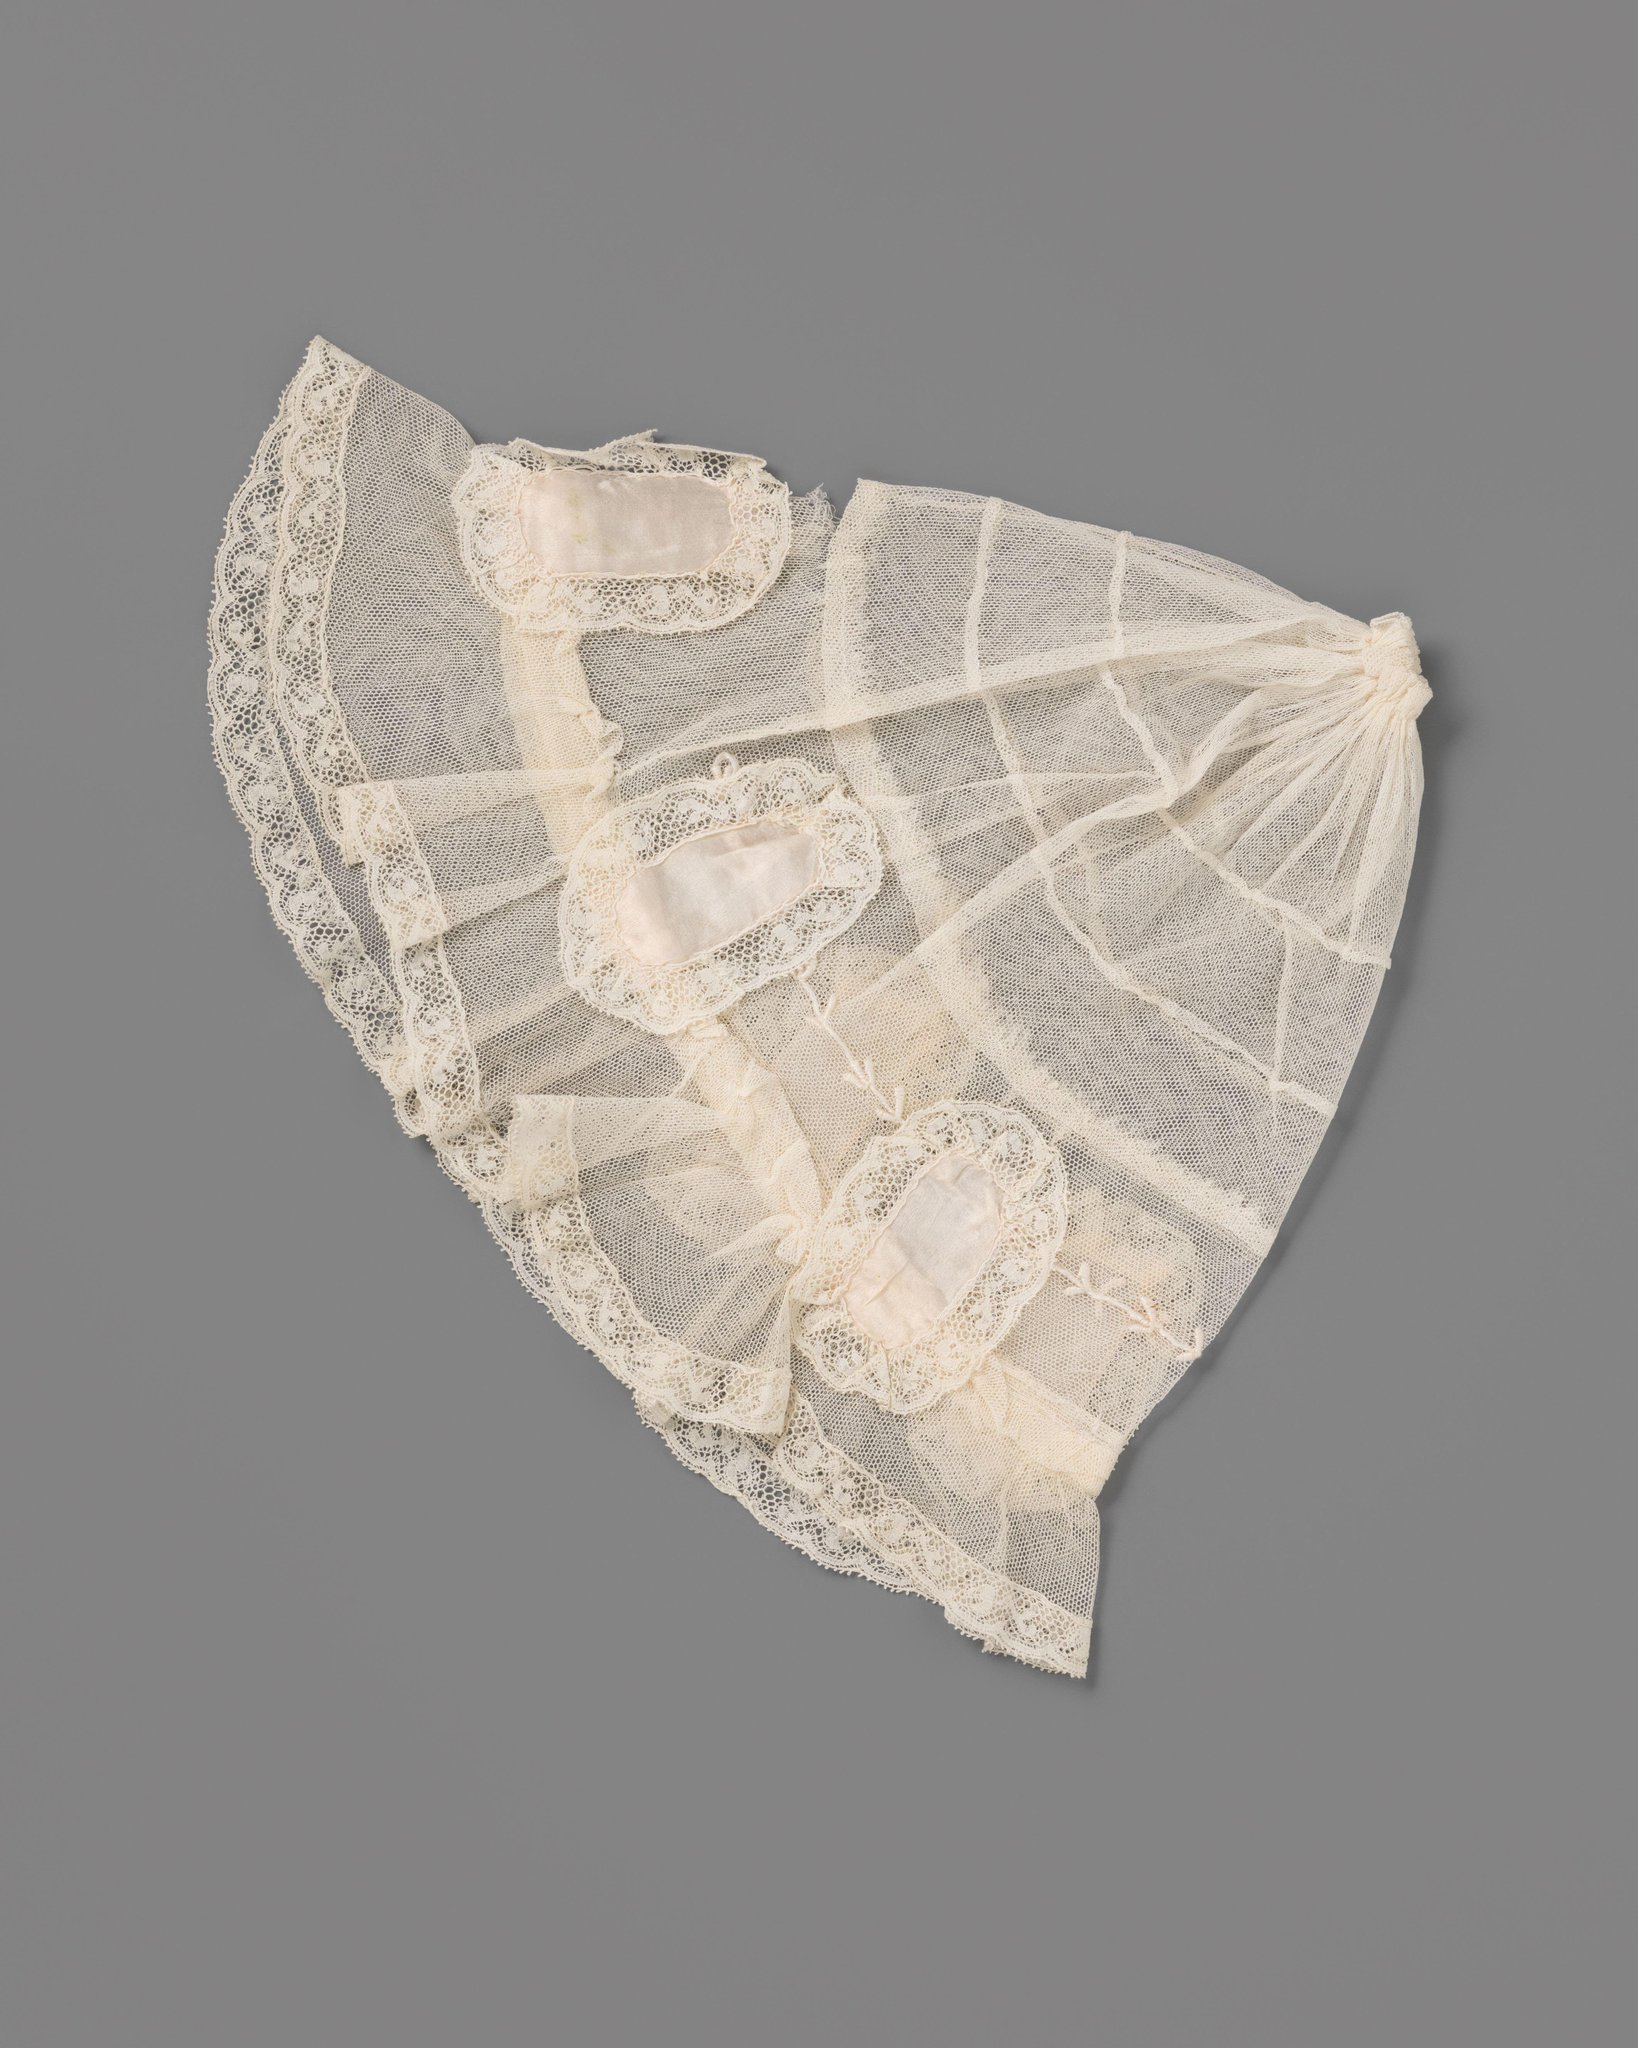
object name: womenswear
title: Négligémuts van tule versierd met Valenciennes-kant en zijde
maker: Anonymous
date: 1910-1925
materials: silk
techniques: lace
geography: western europe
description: Négligémuts van tule. De bol is gerimpeld op de kruin. De pas is versierd met een geborduurde rank. Aan de pas is een rand tule bevestigd die is afgezet met een strook Valenciennes-kant. Op de grens van pas en rand zijn vijf decoraties van lichtroze zijde genaaid die eveneens zijn afgezet met Valenciennes-kant.